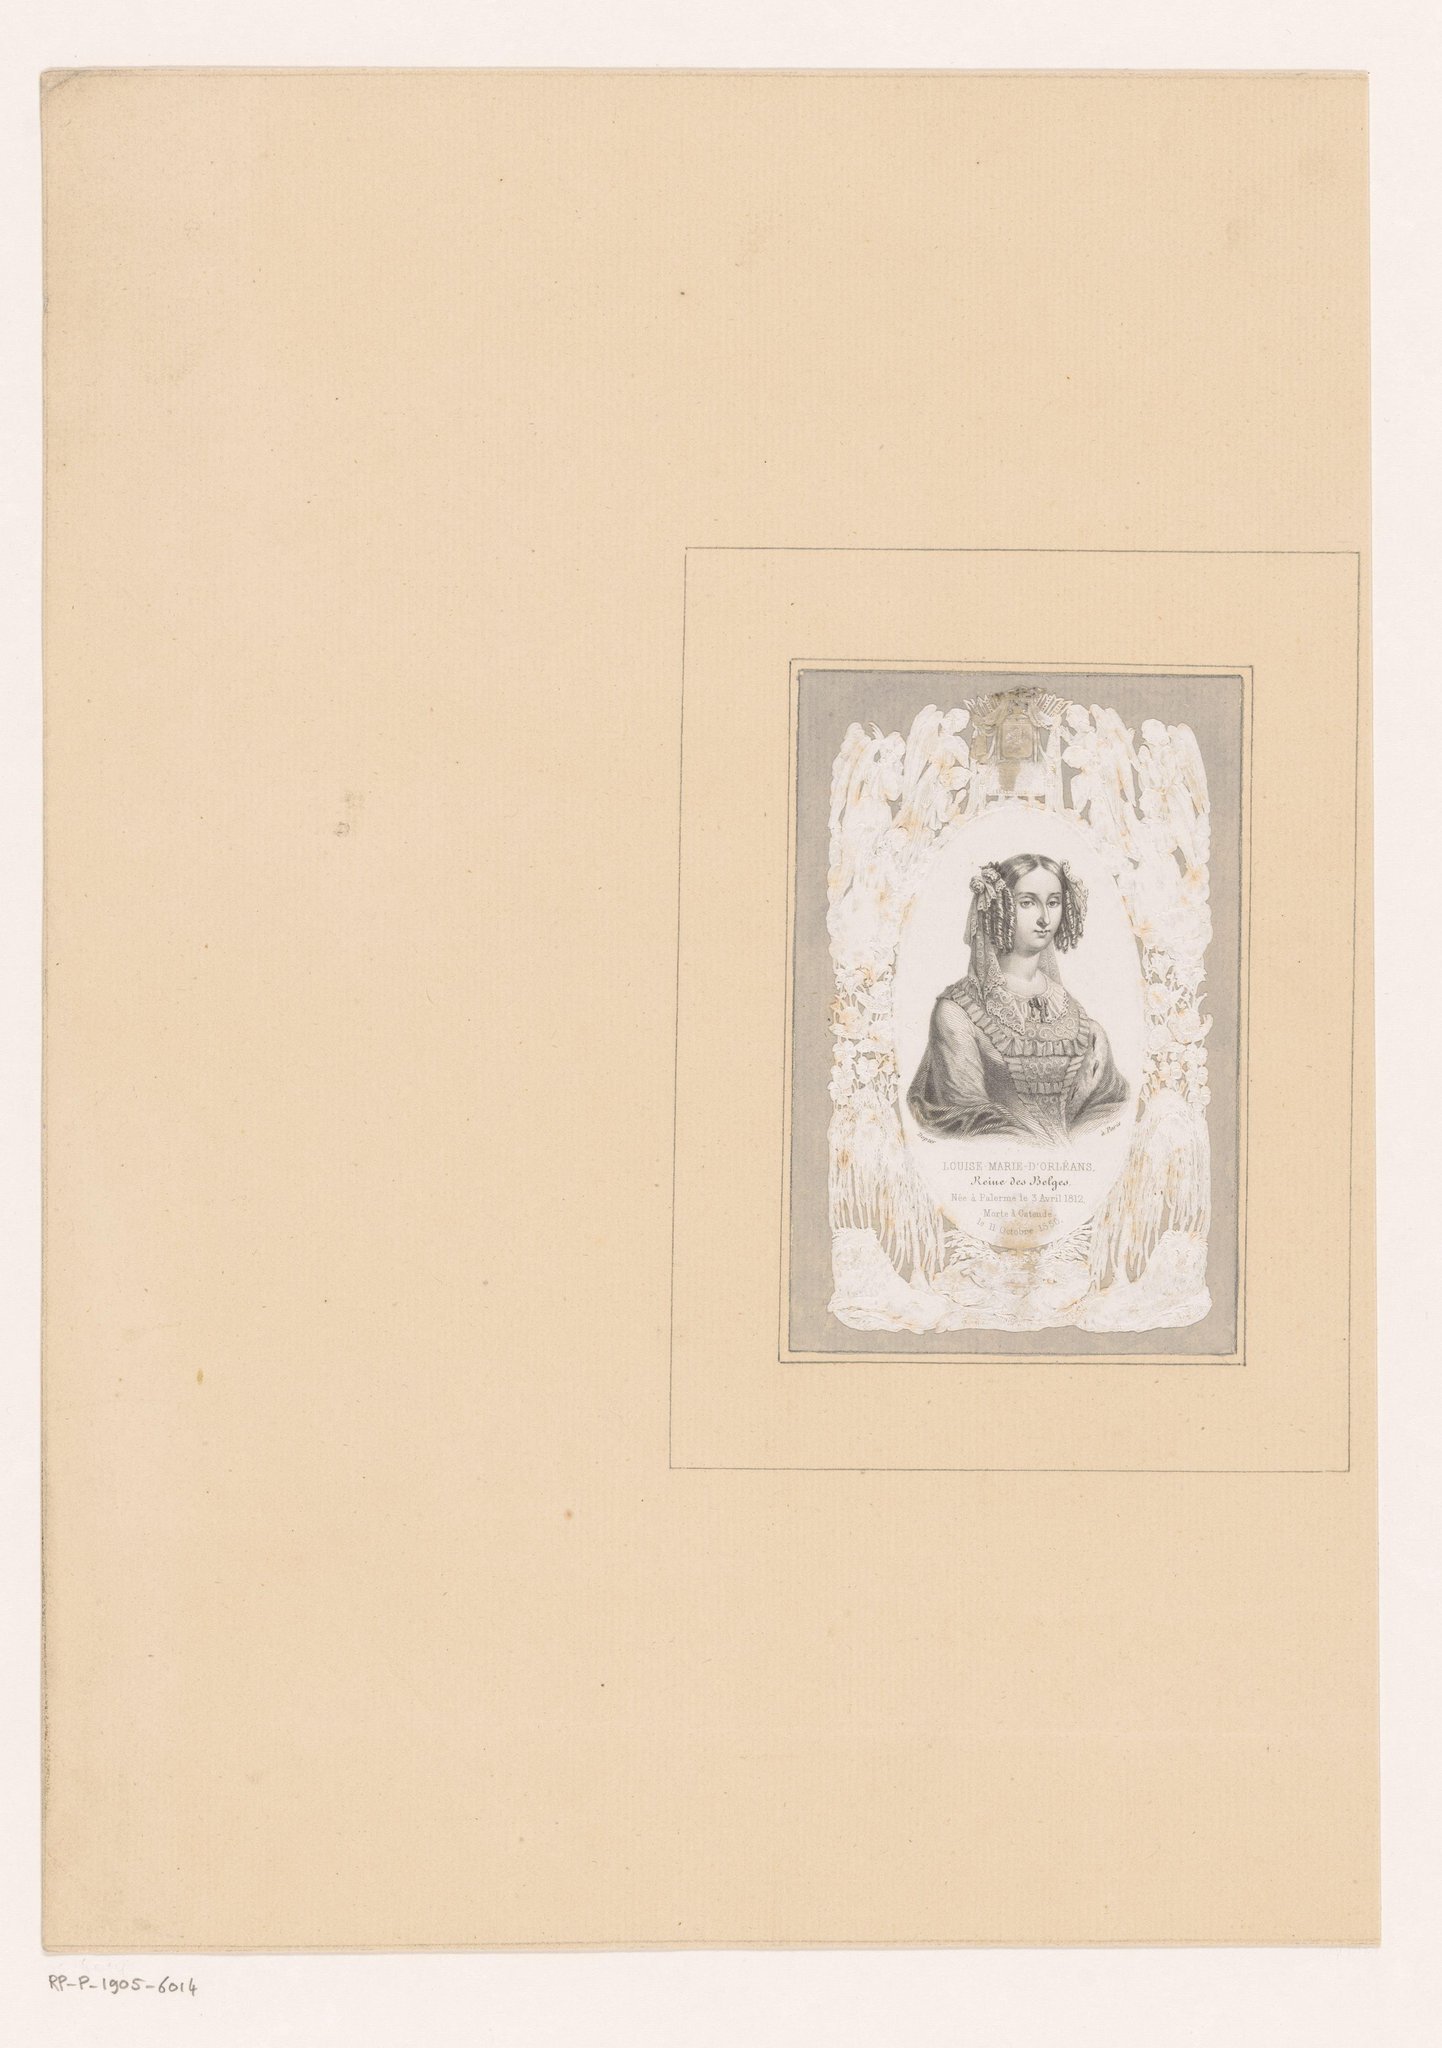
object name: print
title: Portret van Louise Marie van Orléans, koningin van België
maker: jean vincent marie dopter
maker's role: printer, publisher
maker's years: 1807-1859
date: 1850-1859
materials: paper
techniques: manufacturing, engraving, etching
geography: paris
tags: louise marie van orléans (koningin van belgië), historical persons, queen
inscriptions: collector's mark: Lugt 2228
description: Betreft een bidprent voor Louise Marie van Orléans, koningin van België, overleden op 11 oktober 1850.